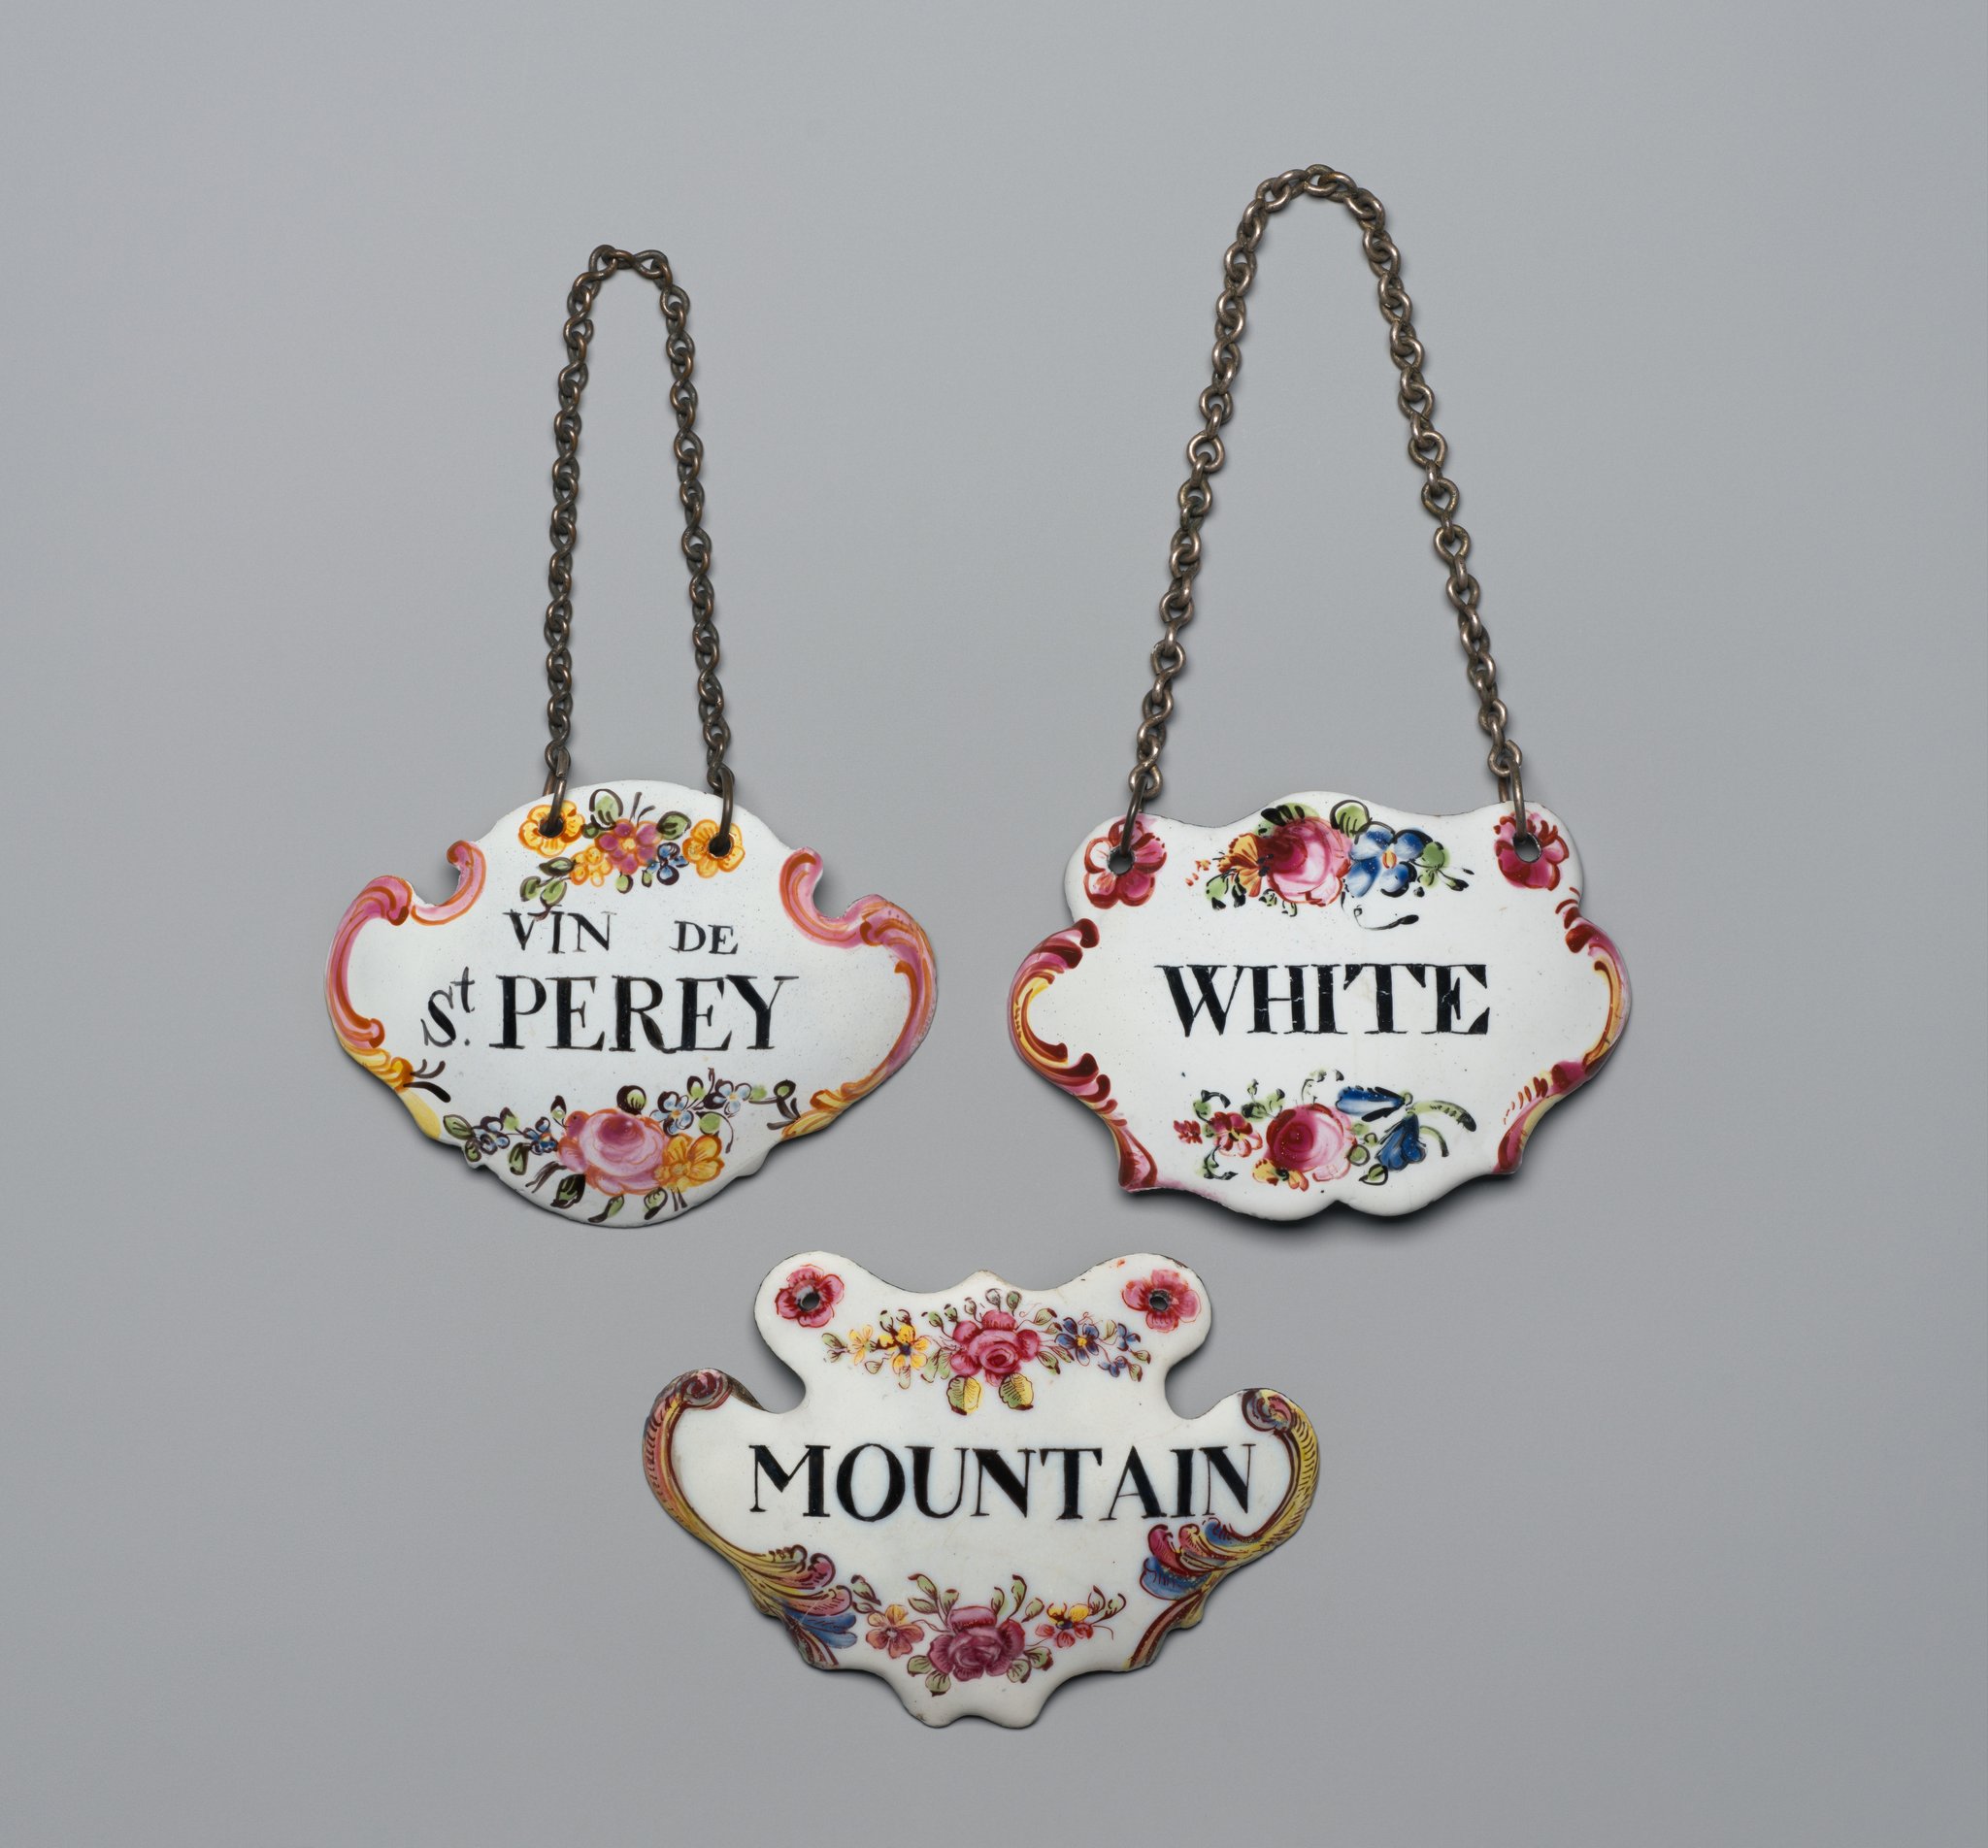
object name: bottle ticket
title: Three bottle tickets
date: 1751-1800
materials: copper, enamel